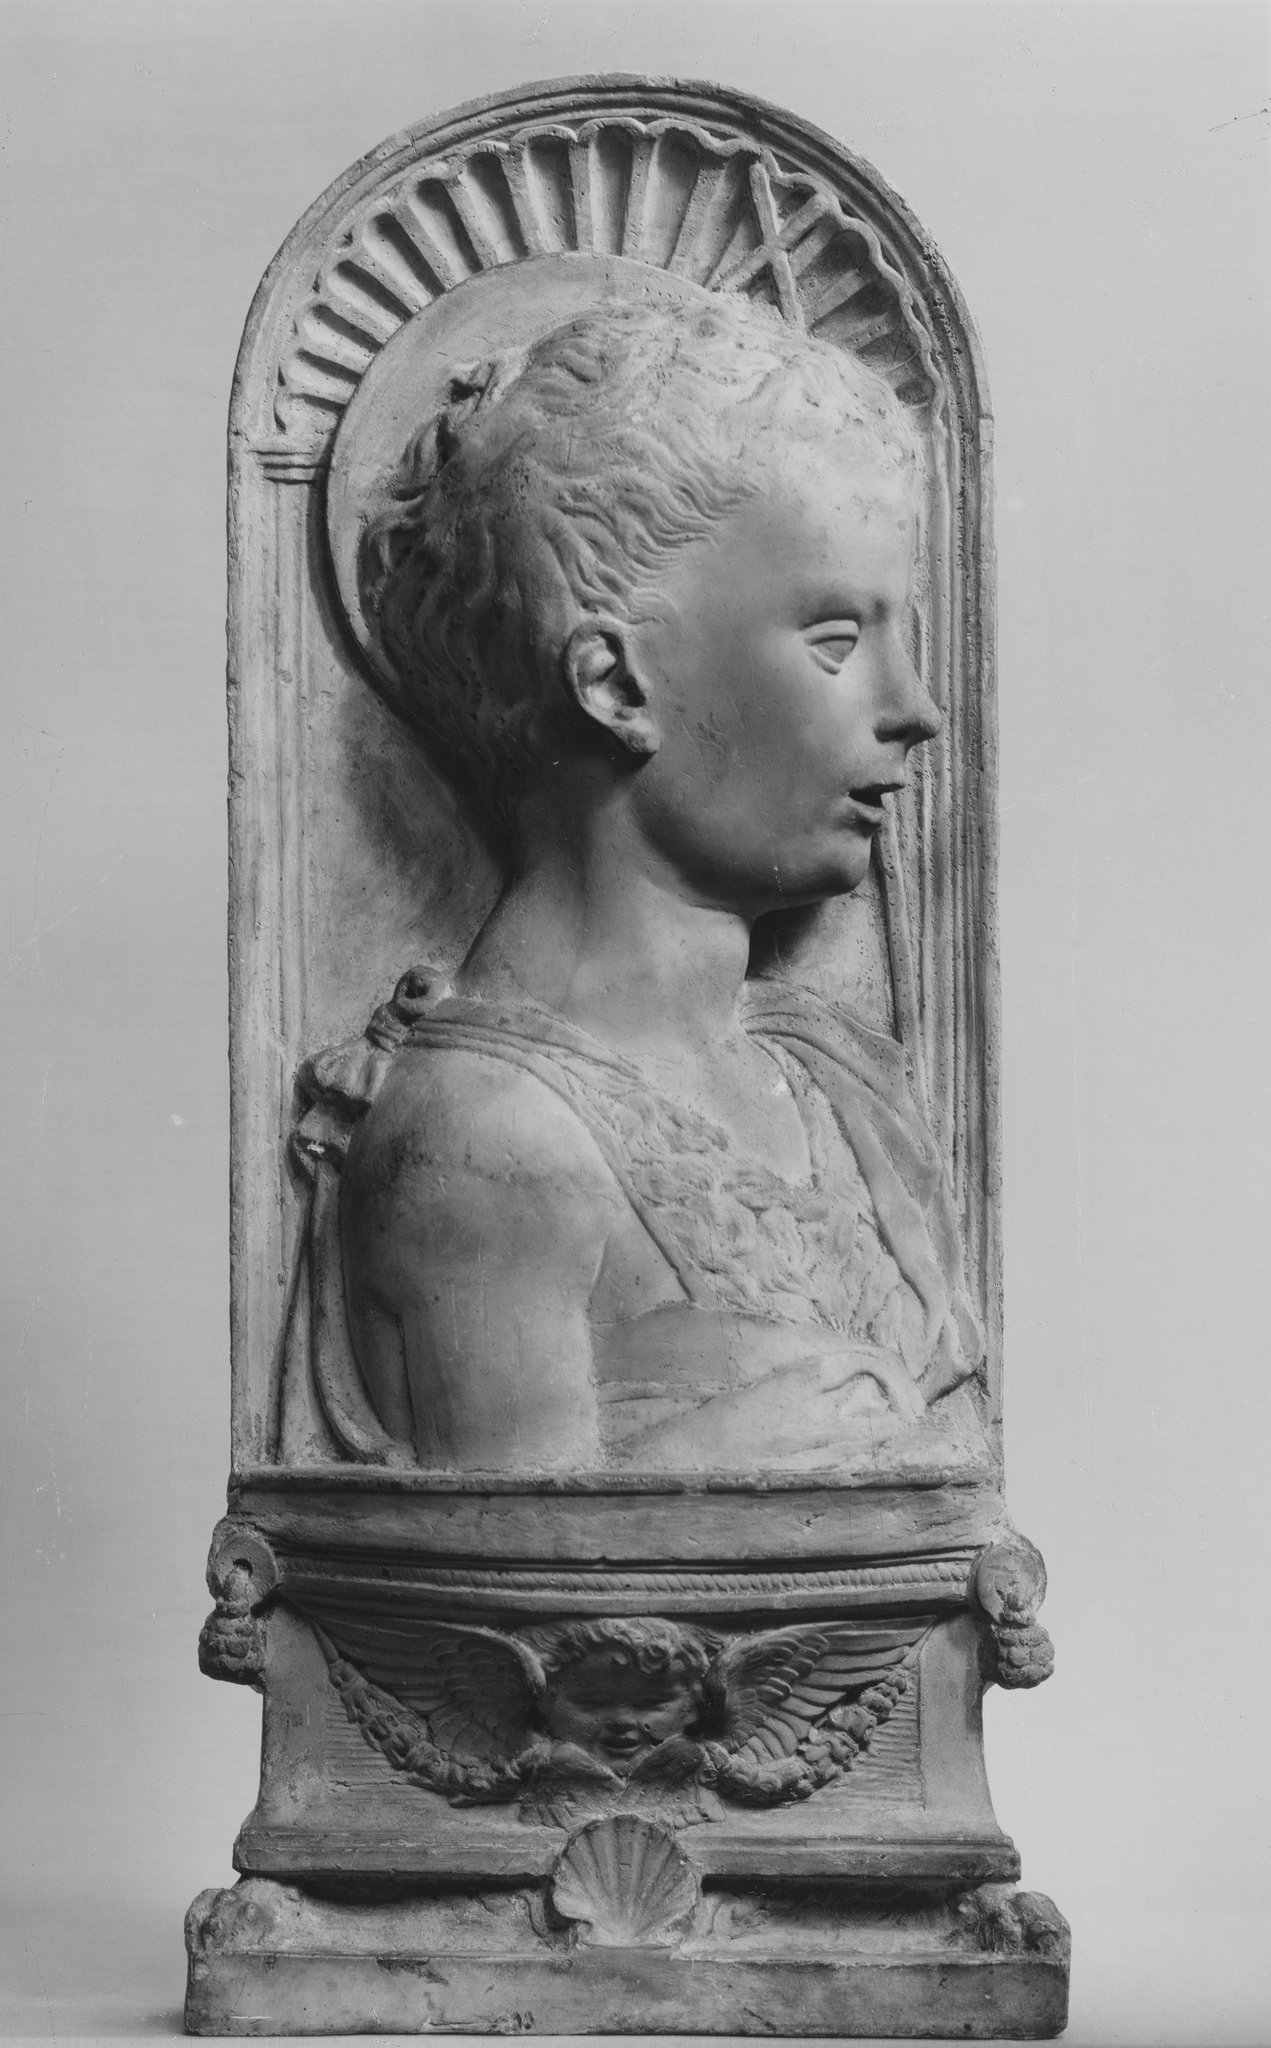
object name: relief bust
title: Young Saint John the Baptist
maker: desiderio da settignano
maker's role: artist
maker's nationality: italian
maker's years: 1435-1469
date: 1401-1500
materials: plaster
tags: boys,profiles,saint john the baptist